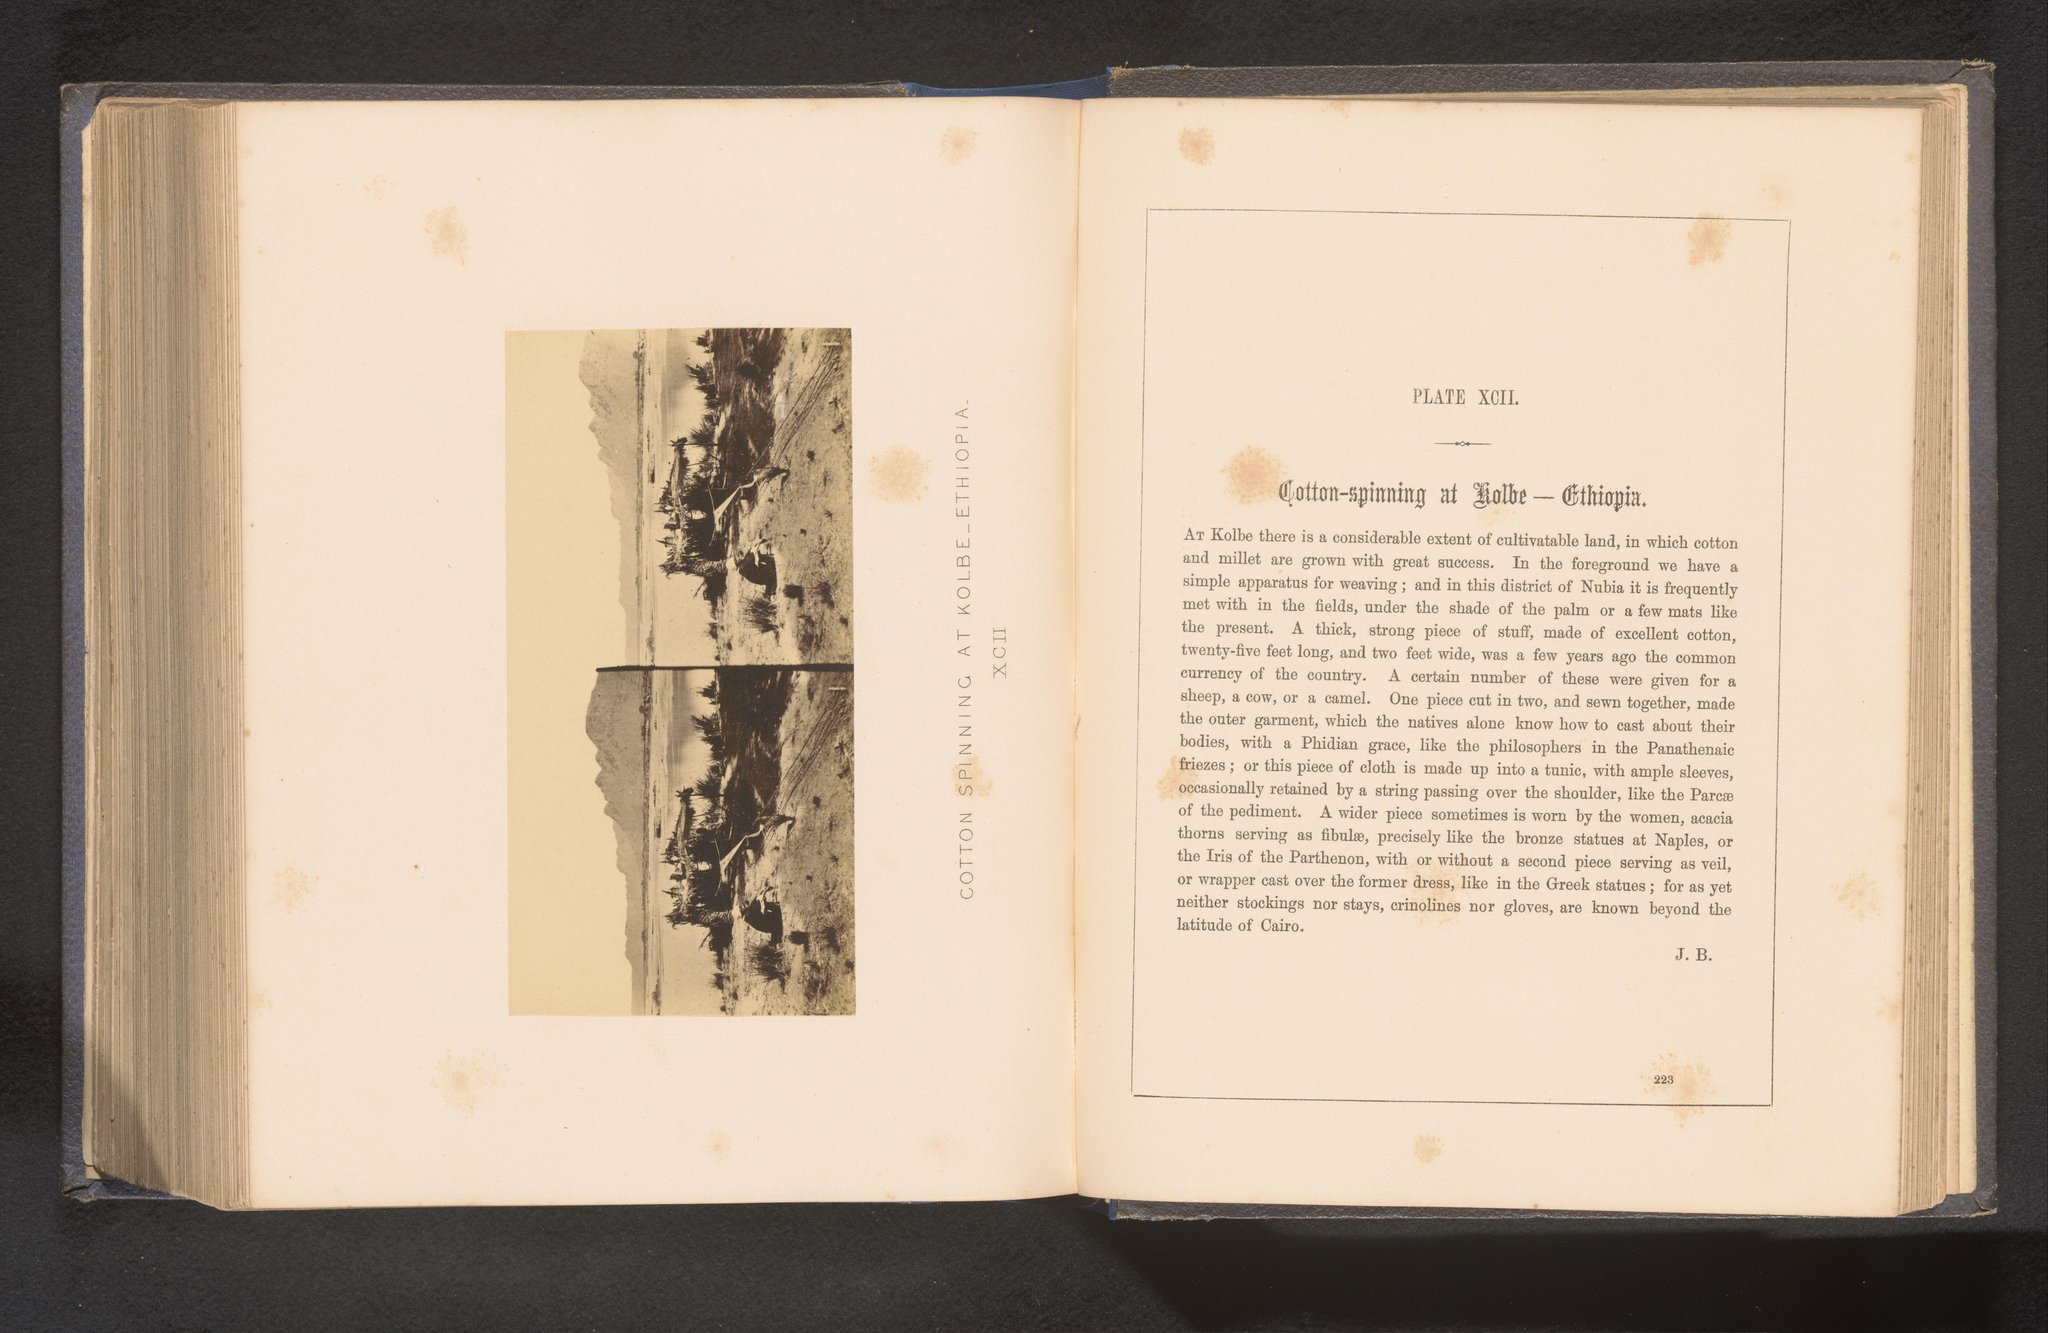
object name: stereograph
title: Cotton spinning at Kolbe - Ethiopia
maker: francis frith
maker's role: publisher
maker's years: 1822-1898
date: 1857-1862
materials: photographic support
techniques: albumen print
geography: ethiopia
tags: landscapes with waters, waterscapes, seascapes (in the temperate zone), spinning (manufacture of yarn)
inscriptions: name: ‘Frith’, number: ‘XCII’